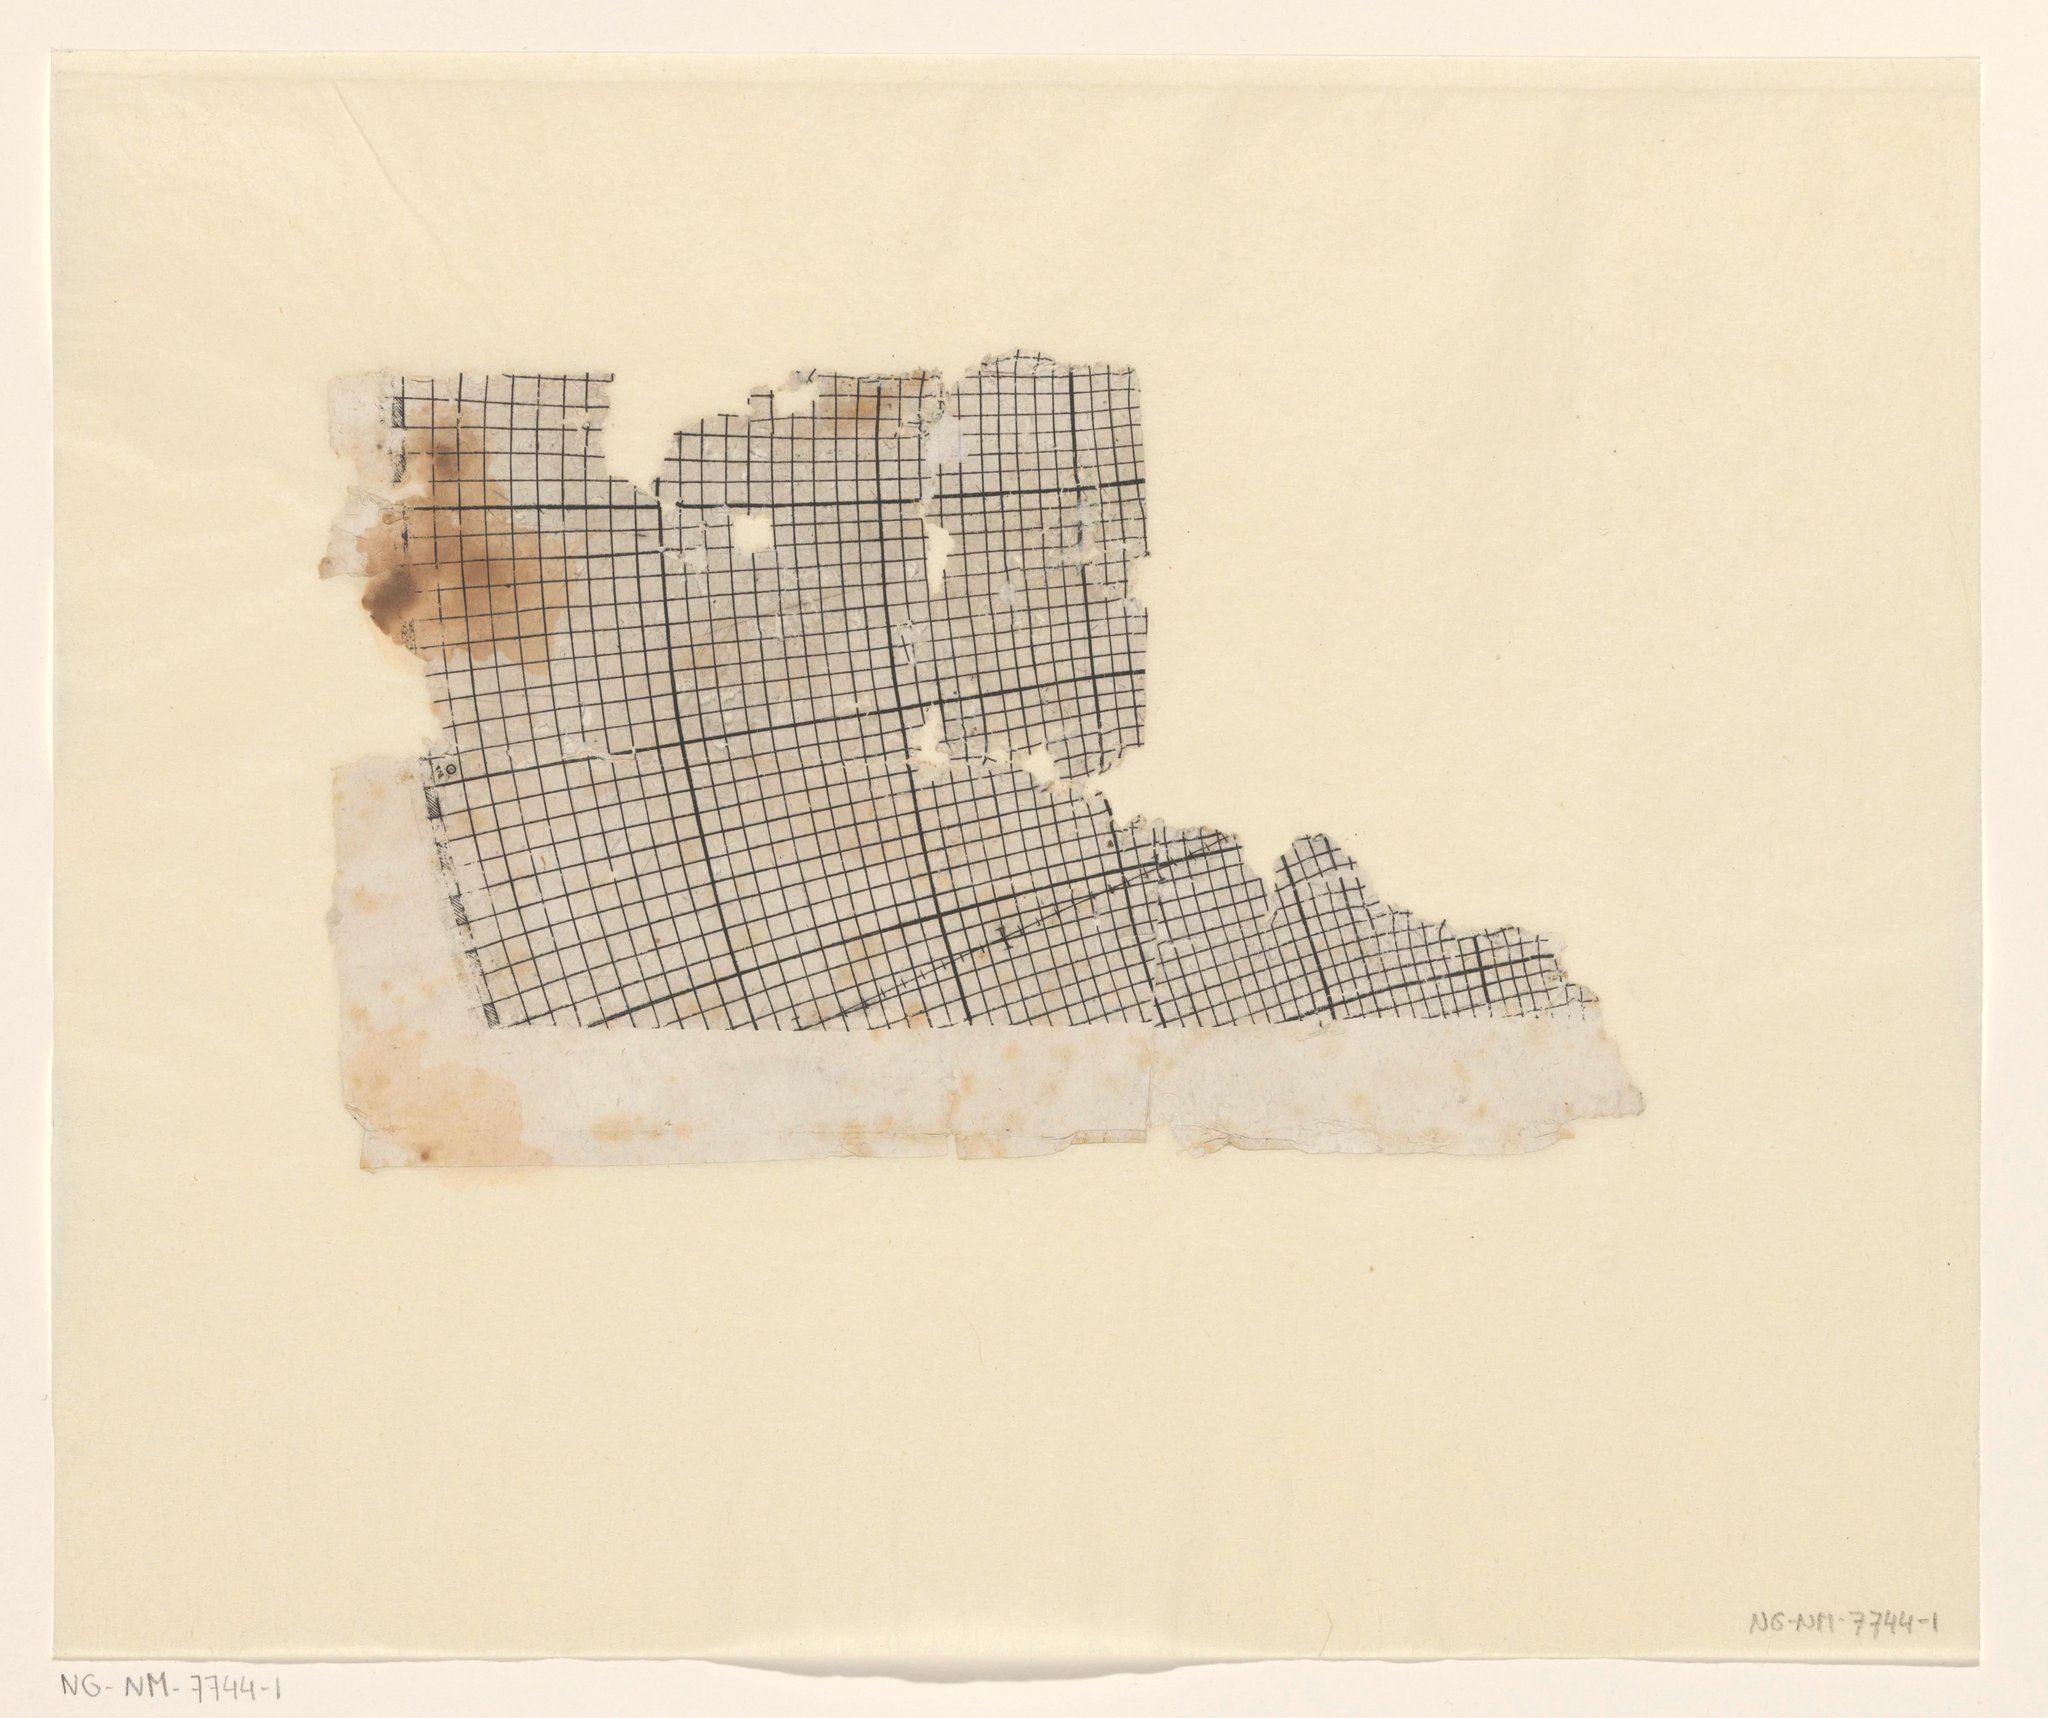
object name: print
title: Fragment van kaartnet van noordelijk halfrond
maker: Anonymous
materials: paper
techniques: engraving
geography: northern netherlands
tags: maps, atlases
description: De prenten en kaarten in de Nova Zembla collectie zijn tijdens een expeditie van Willem Barendsz en Jacob van Heemskerk in 1596-1597 noodgedwongen in het winterkamp, het ‘Behouden Huis’, op het eiland achtergelaten. Bijna drie eeuwen later, in 1871, keerde de Noor Elling Carlsen terug naar Nova Zembla en vond daar de restanten van het ‘Behouden Huis, inclusief een groot deel van de inventaris. Een deel van de prenten, in de vorm van aaneengekoekte kluiten, werd toen ook teruggevonden. De papierkluiten waren soms op meerdere plekken gebroken. Tussen 1975-1979 zijn de prenten van elkaar gescheiden. Dit leverde in totaal ca. 1000 fragmenten van ca. 400 afdrukken van ca. 150 verschillende prenten op. Voor zover mogelijk zijn de fragmenten samengevoegd en zijn de prenten gereconstrueerd.